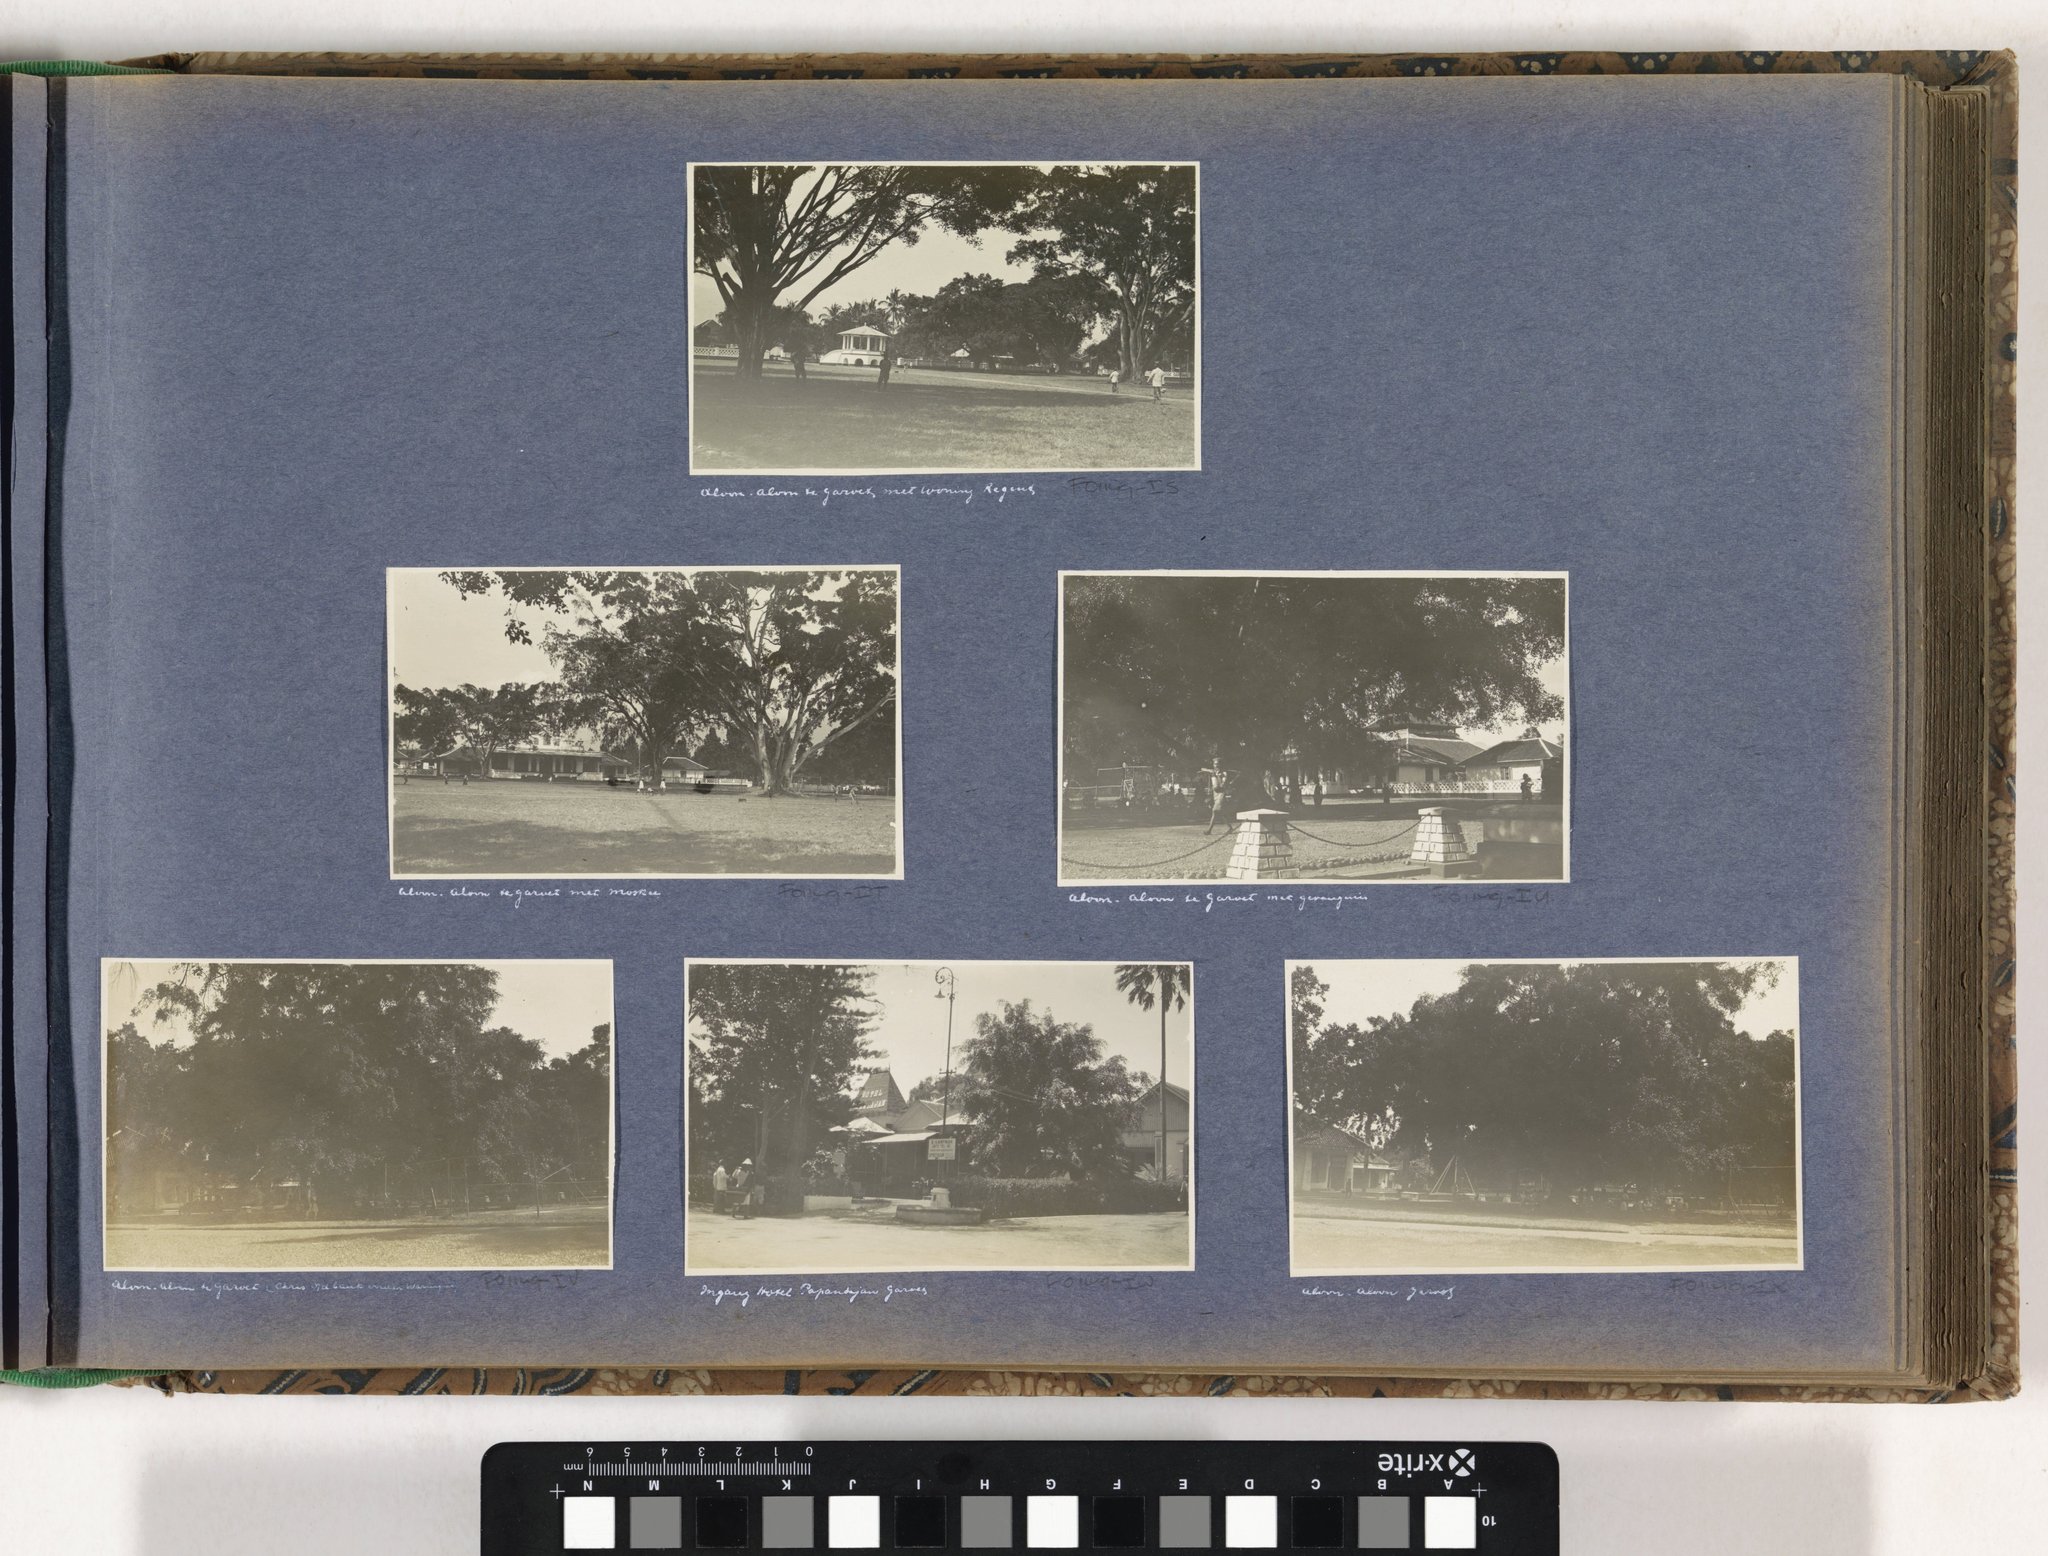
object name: photograph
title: Straathoek in Garut met de ingang van Hotel Papandajan en naambord van artsenpraktijk A. Kampman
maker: Anonymous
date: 1900-1920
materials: paper, photographic support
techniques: gelatin silver print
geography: garut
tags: physician, doctor, hotel, hostelry, inn, street (+ city(-scape) with figures, staffage)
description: Onderdeel van reisalbum met foto's van bedrijvigheid en bezienswaardigheden op Sumatra en Java en van de reis naar en van Nederlands-Indië.